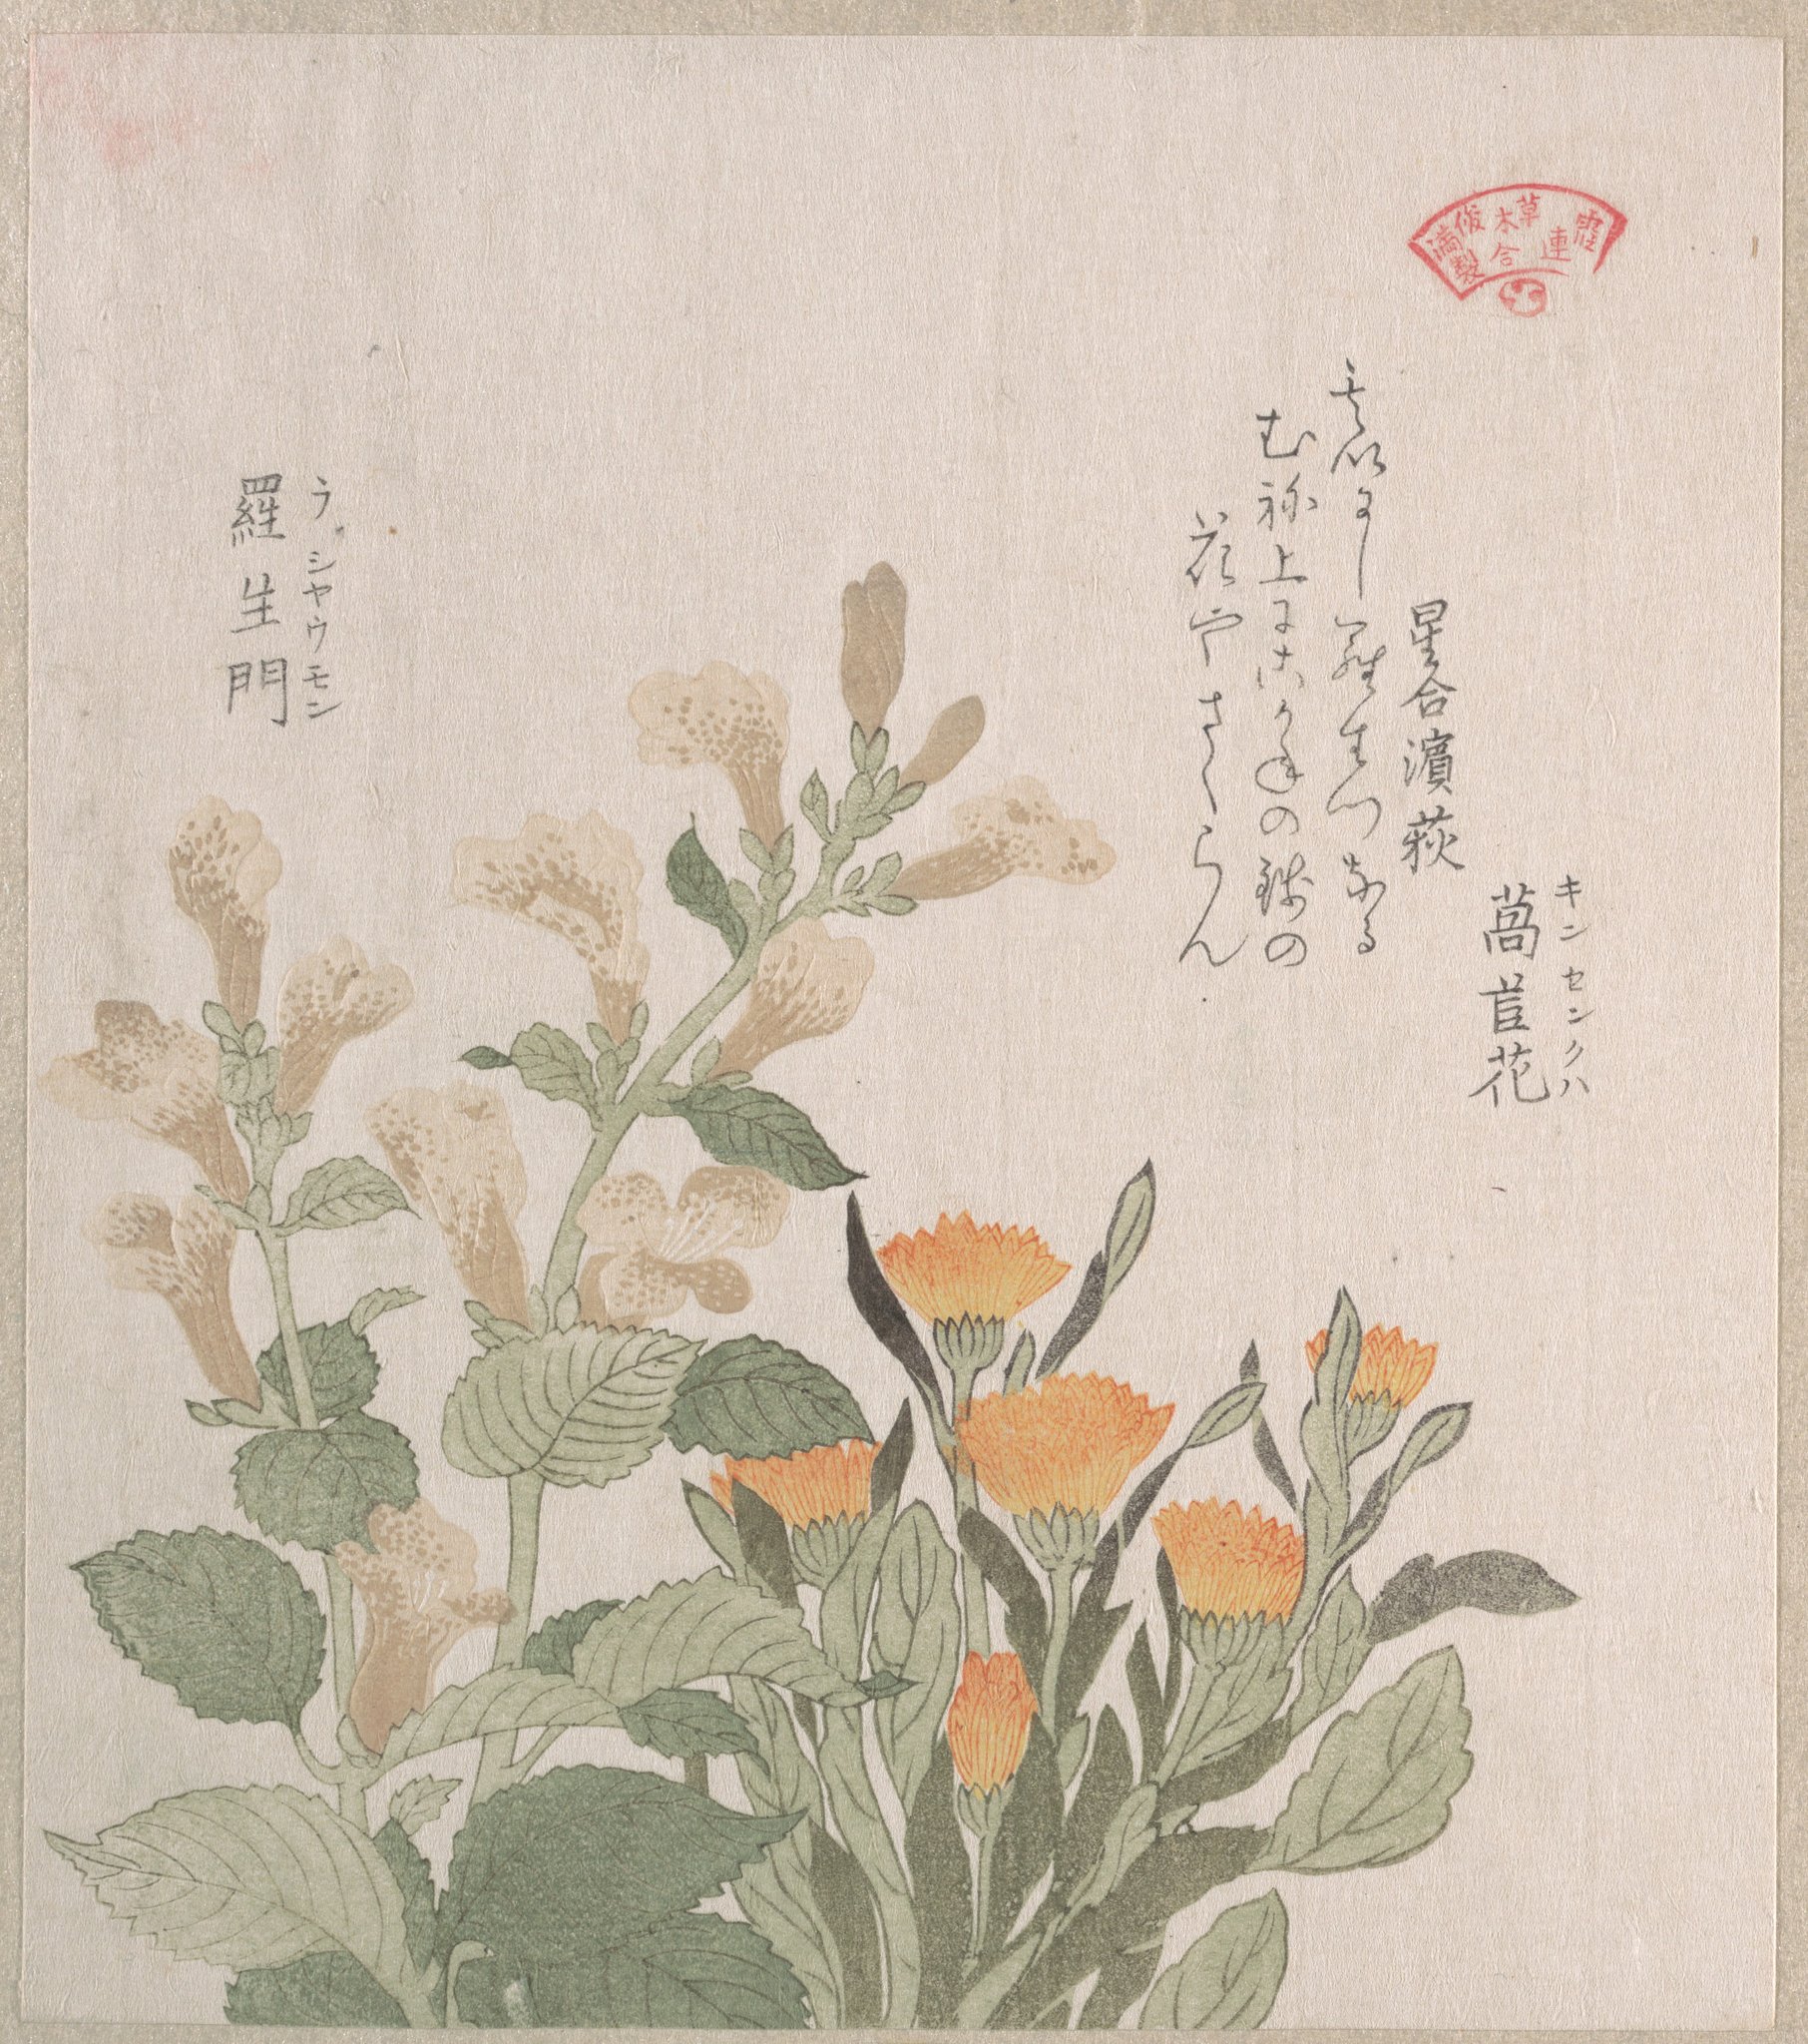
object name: print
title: The Common Marigold and The Rajoman Flowers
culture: japanese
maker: kubo shunman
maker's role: artist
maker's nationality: japanese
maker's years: 1757-1820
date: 1801-1900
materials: ink, paper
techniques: surimono, woodblock print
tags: flowers,leaves